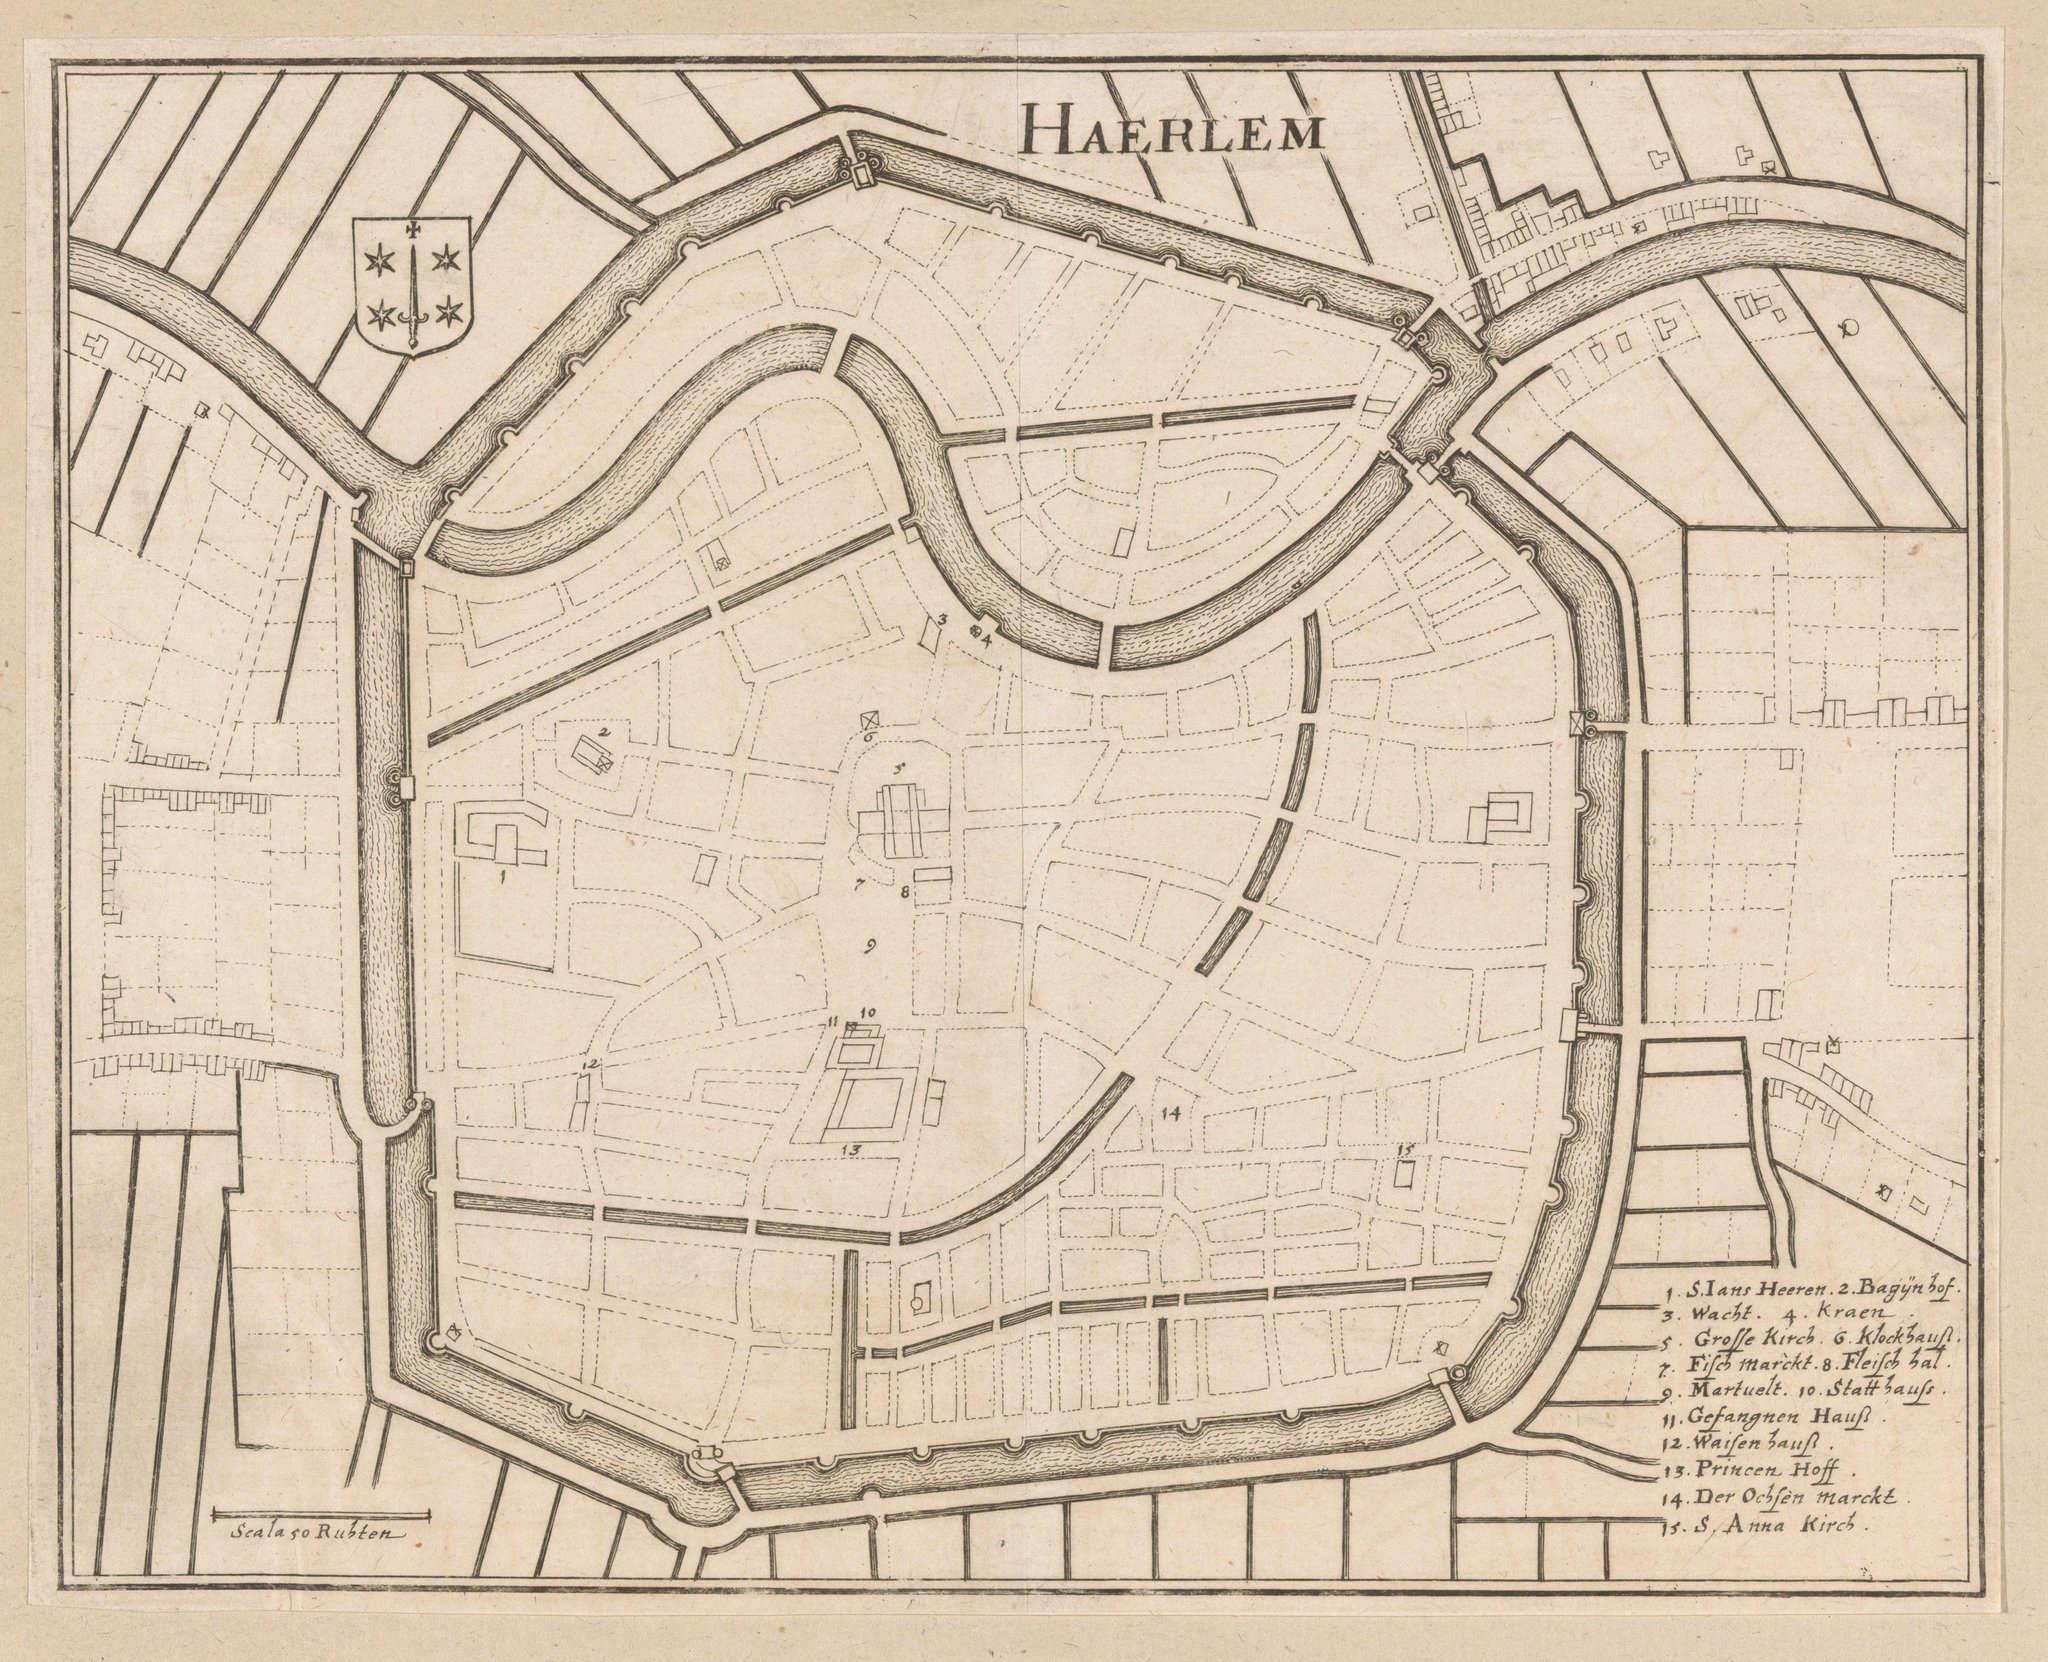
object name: area plan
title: Vestingplattegrond van Haarlem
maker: caspar merian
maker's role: print maker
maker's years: 1627-1689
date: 1654-1700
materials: paper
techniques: engraving, etching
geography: frankfurt am main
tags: coat of arms (as symbol of the state, etc.) (+ city; municipal), fortified city, maps of cities, haarlem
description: Prent gebruikt in: Zeiller, Martin. M.Z. Topographia Circuli Burgundici Oder Beschreibung une Eigentliche Abbildung der Vornehmsten Örter in dem Hochlöblichen Burgund- un Niderlandischen Crayse. Frankfurt am Main: Caspar Merian, 1654. Of in: Zeiller, Martin. M. Z. Topographia Germaniae-Inferioris vel Circuli-Burgundici, das ist Beschreibung (…). Frankfurt am Main: Caspar Merian, 1659. Of in een van de twee latere uitgaven van deze publicatie die, hoewel het jaar 1659 erin staat vermeld als jaar van uitgave, zijn uitgegeven in respectievelijk ca. 1670 en ca. 1700.